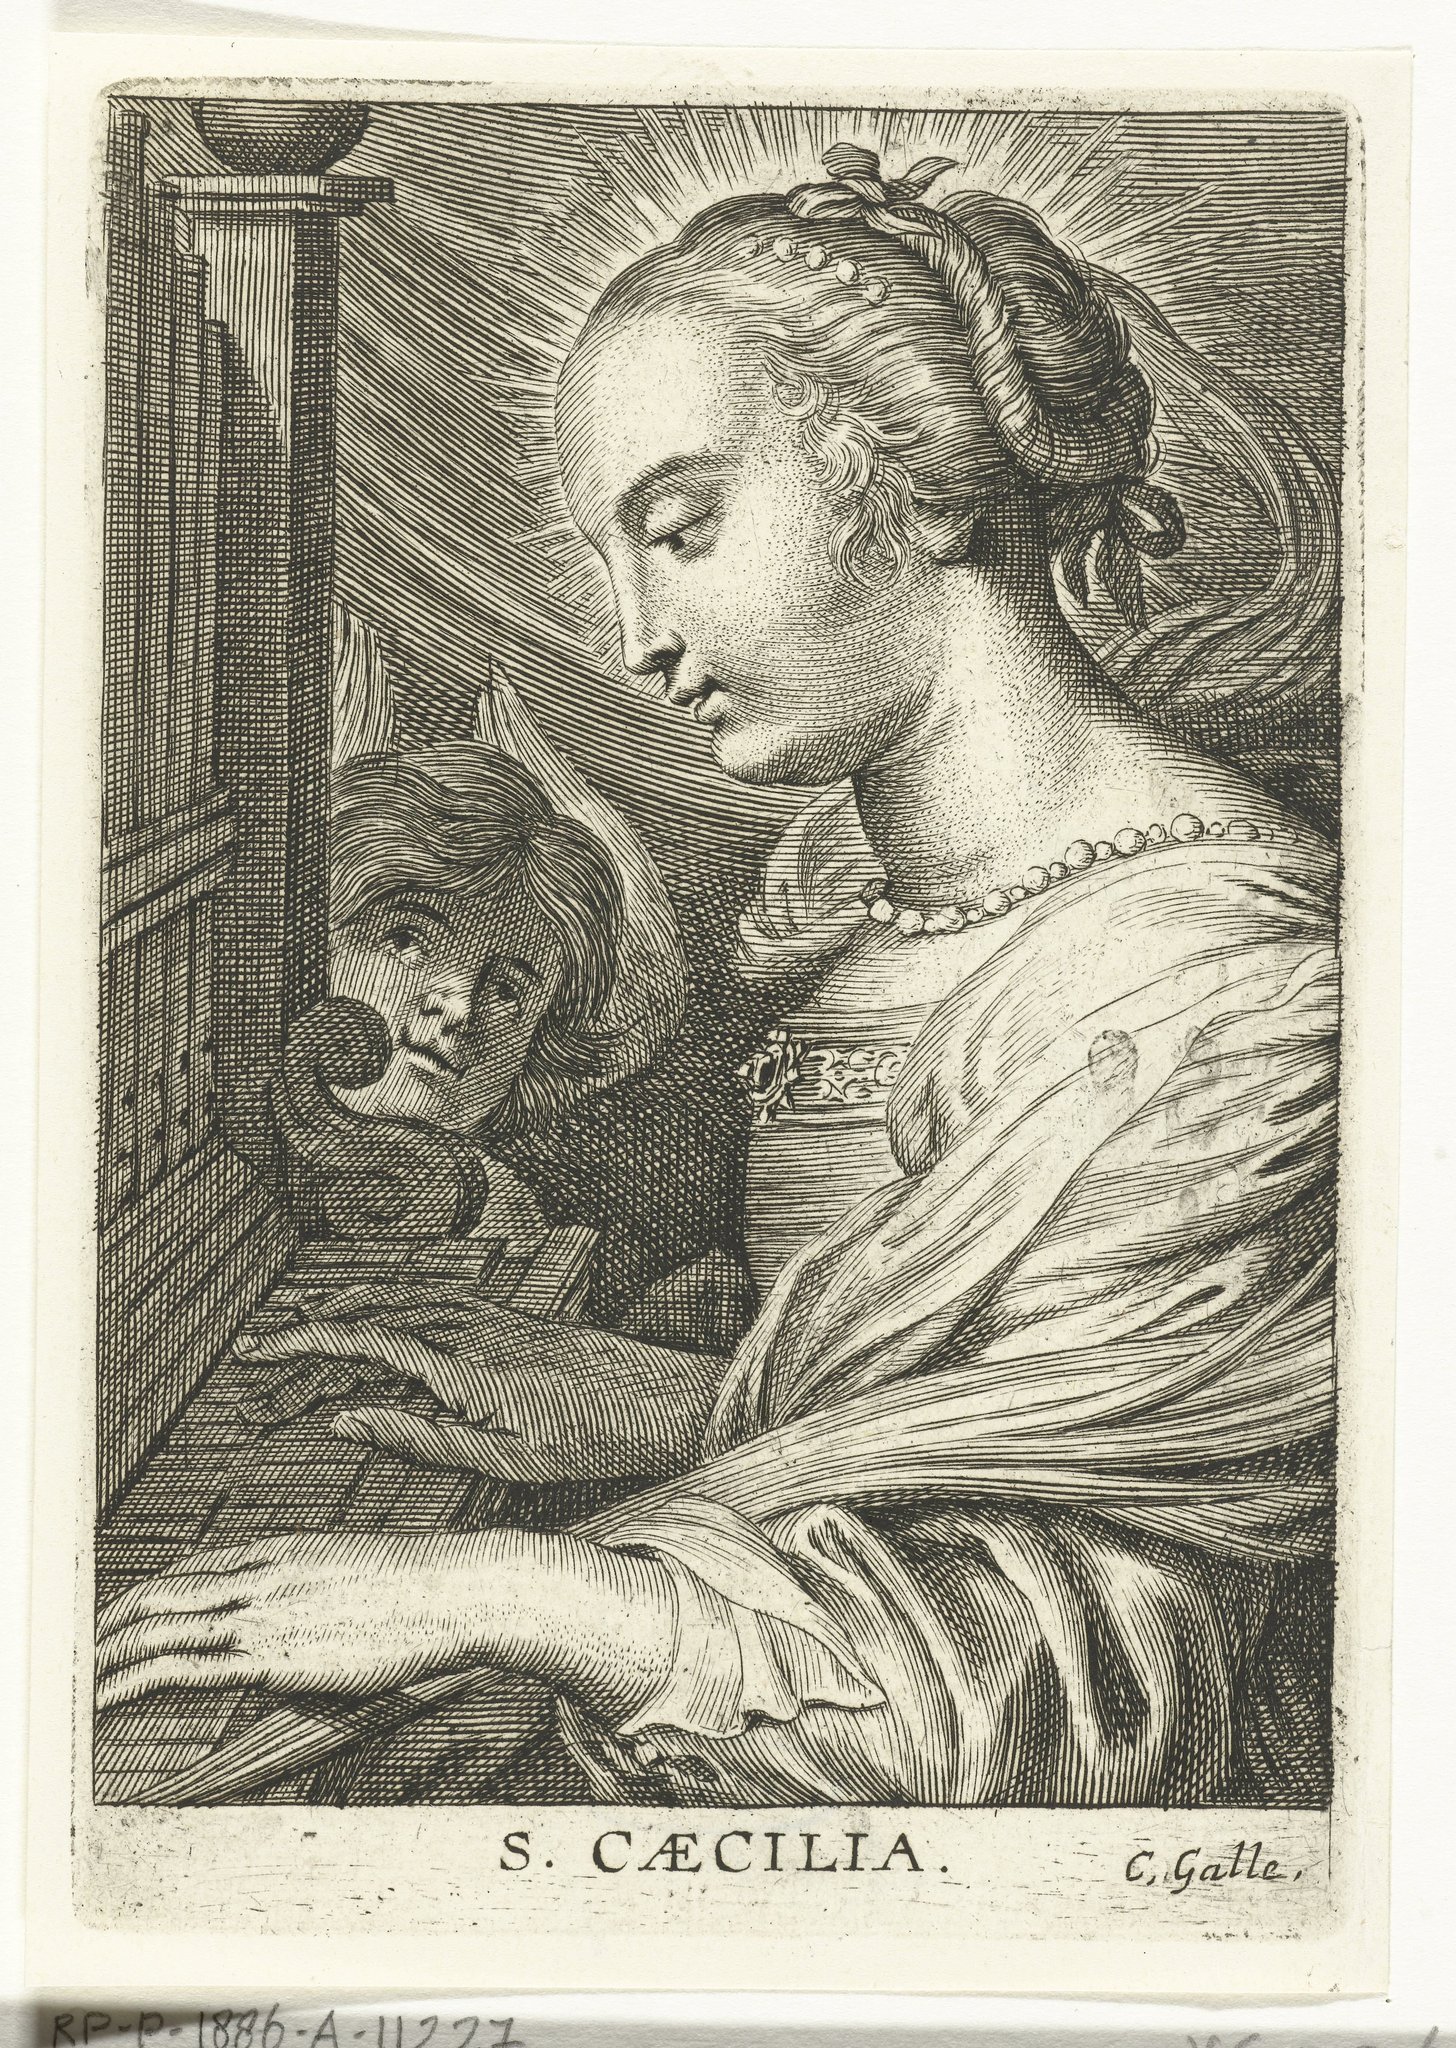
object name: print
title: S. Caecilia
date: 1596-1659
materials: paper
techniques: engraving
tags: the virgin martyr cecilia of rome; possible attributes: falcon, musical instruments, organ, wreath of roses and lilies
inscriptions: collector's mark: Lugt 2228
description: Prent naar ontwerp van Peter Paul Rubens.